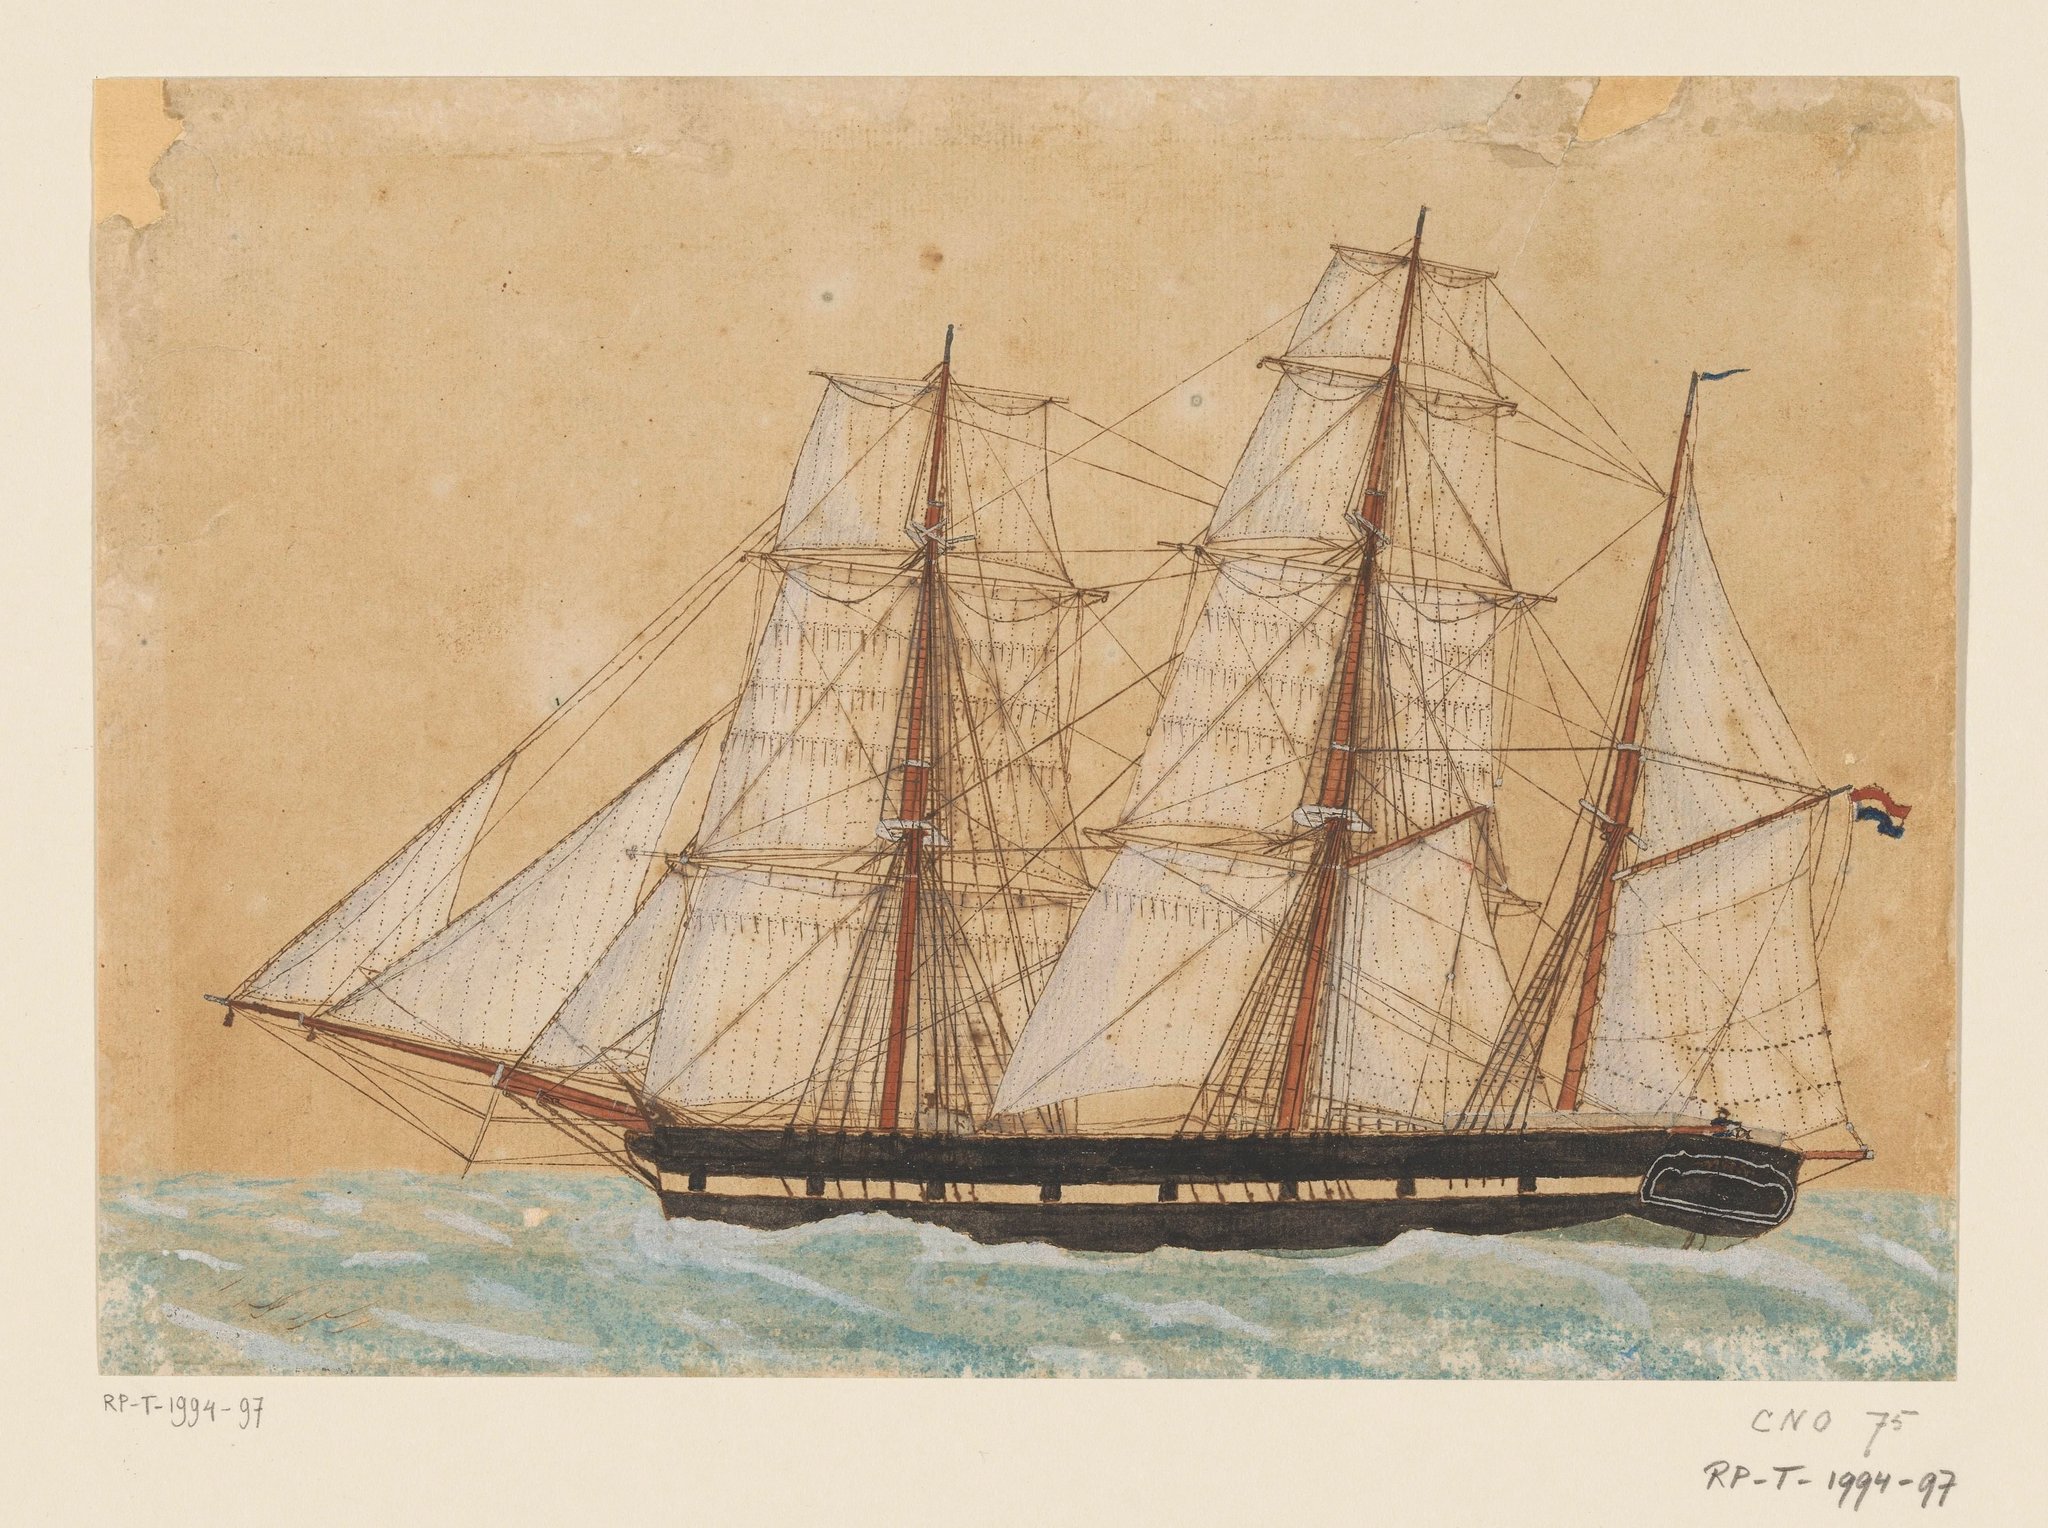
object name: drawing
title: Bark op zee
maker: Anonymous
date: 1858-1860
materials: paint, ink, paper, pencil, watercolor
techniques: brush, pen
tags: sailing-ship, sailing-boat